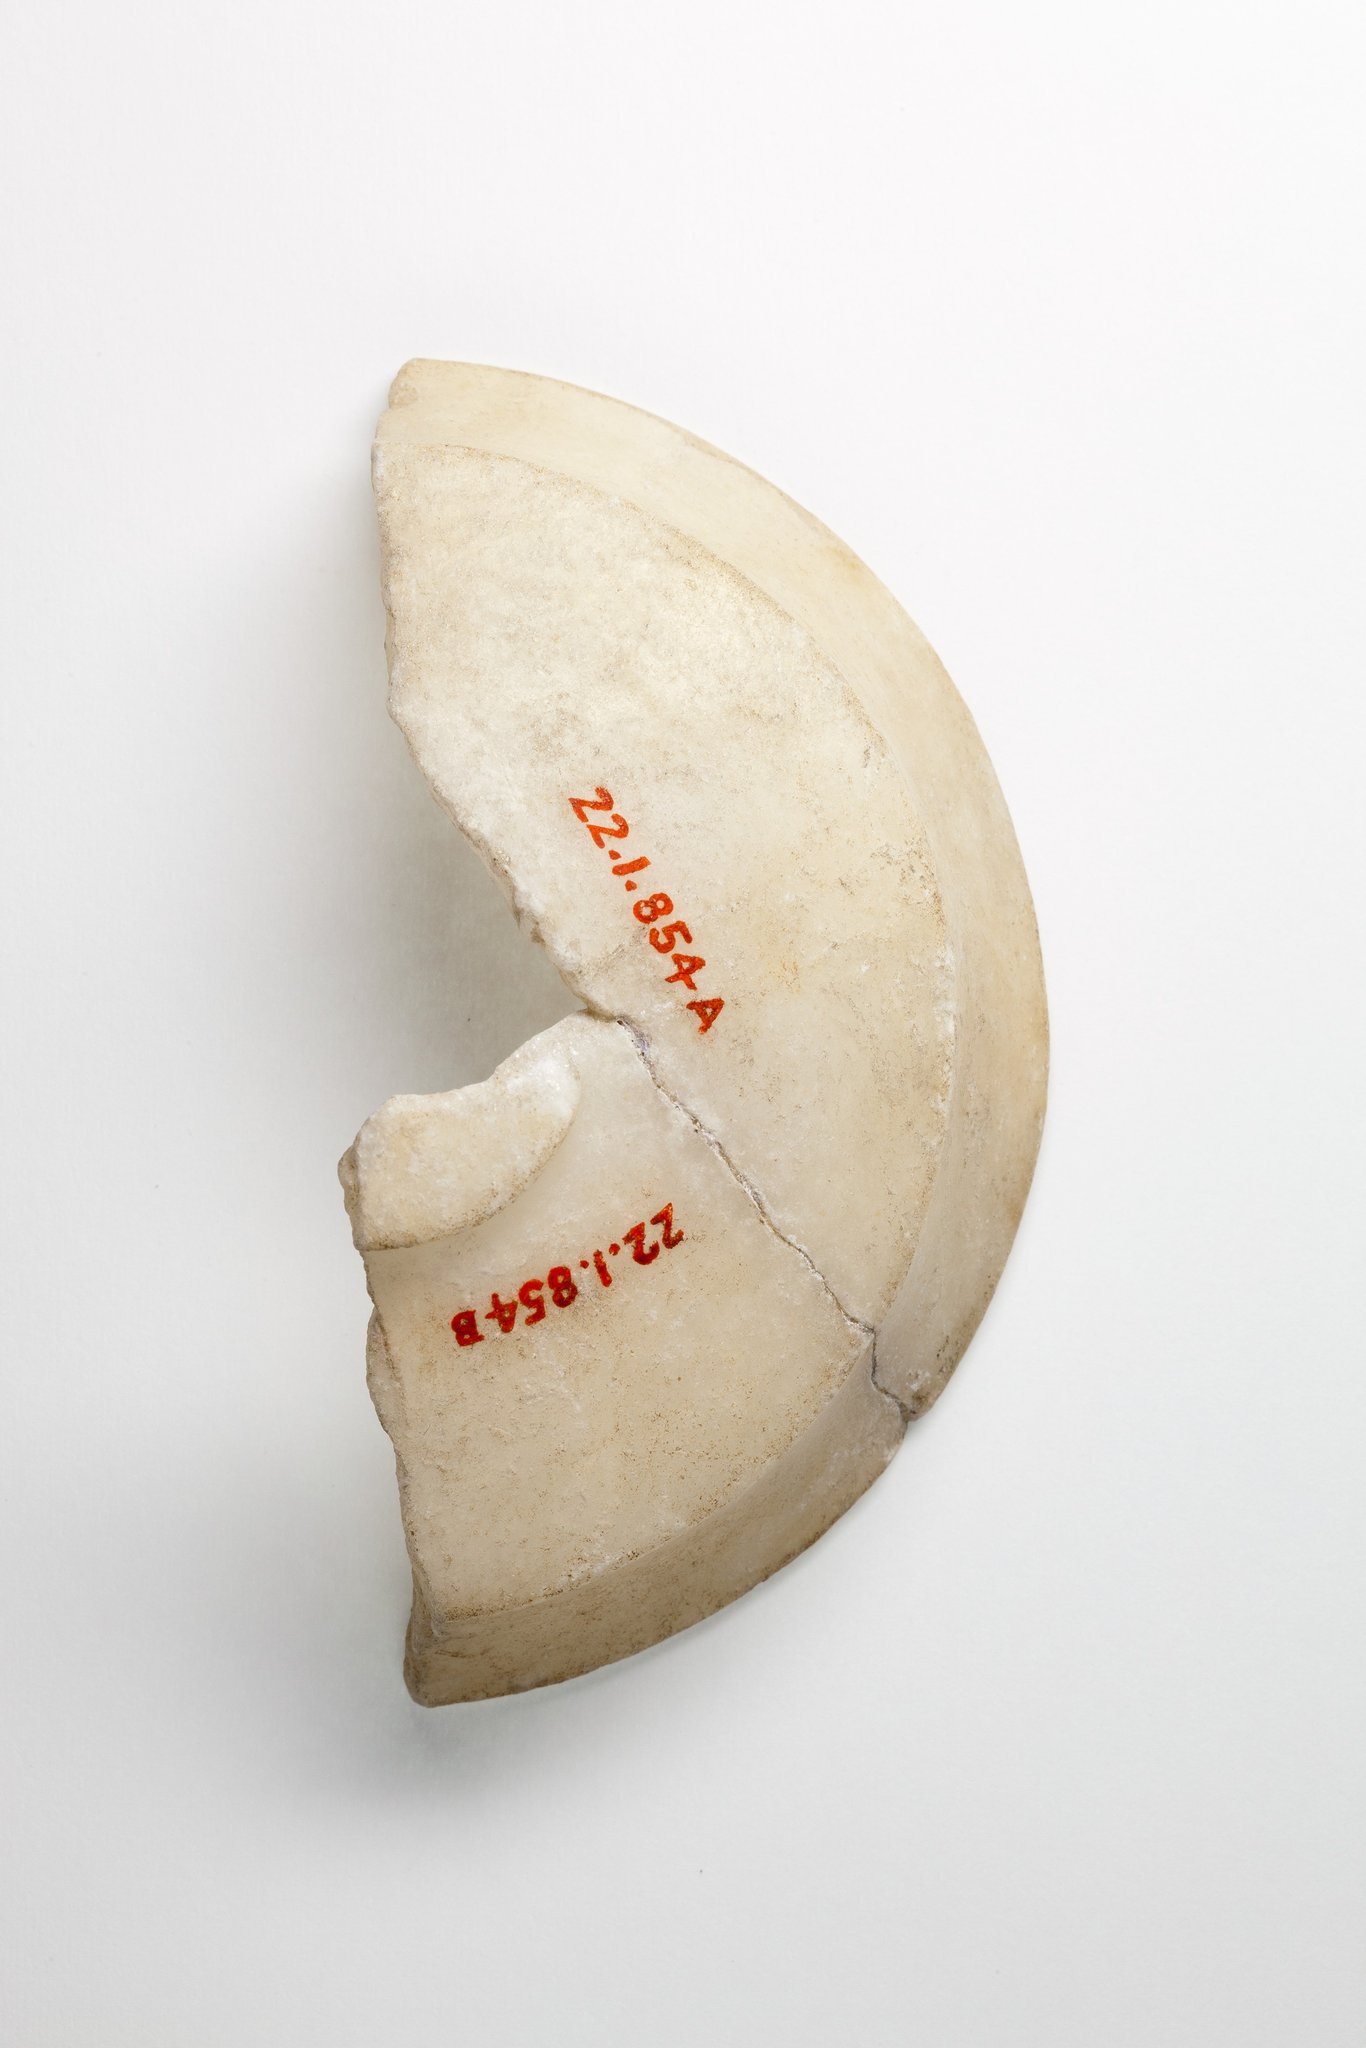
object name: fragment of a bowl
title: Bowl fragment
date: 1981-1640 BCE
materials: stone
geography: egypt